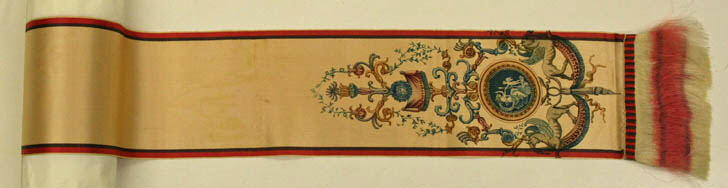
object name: sash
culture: french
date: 1788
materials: silk